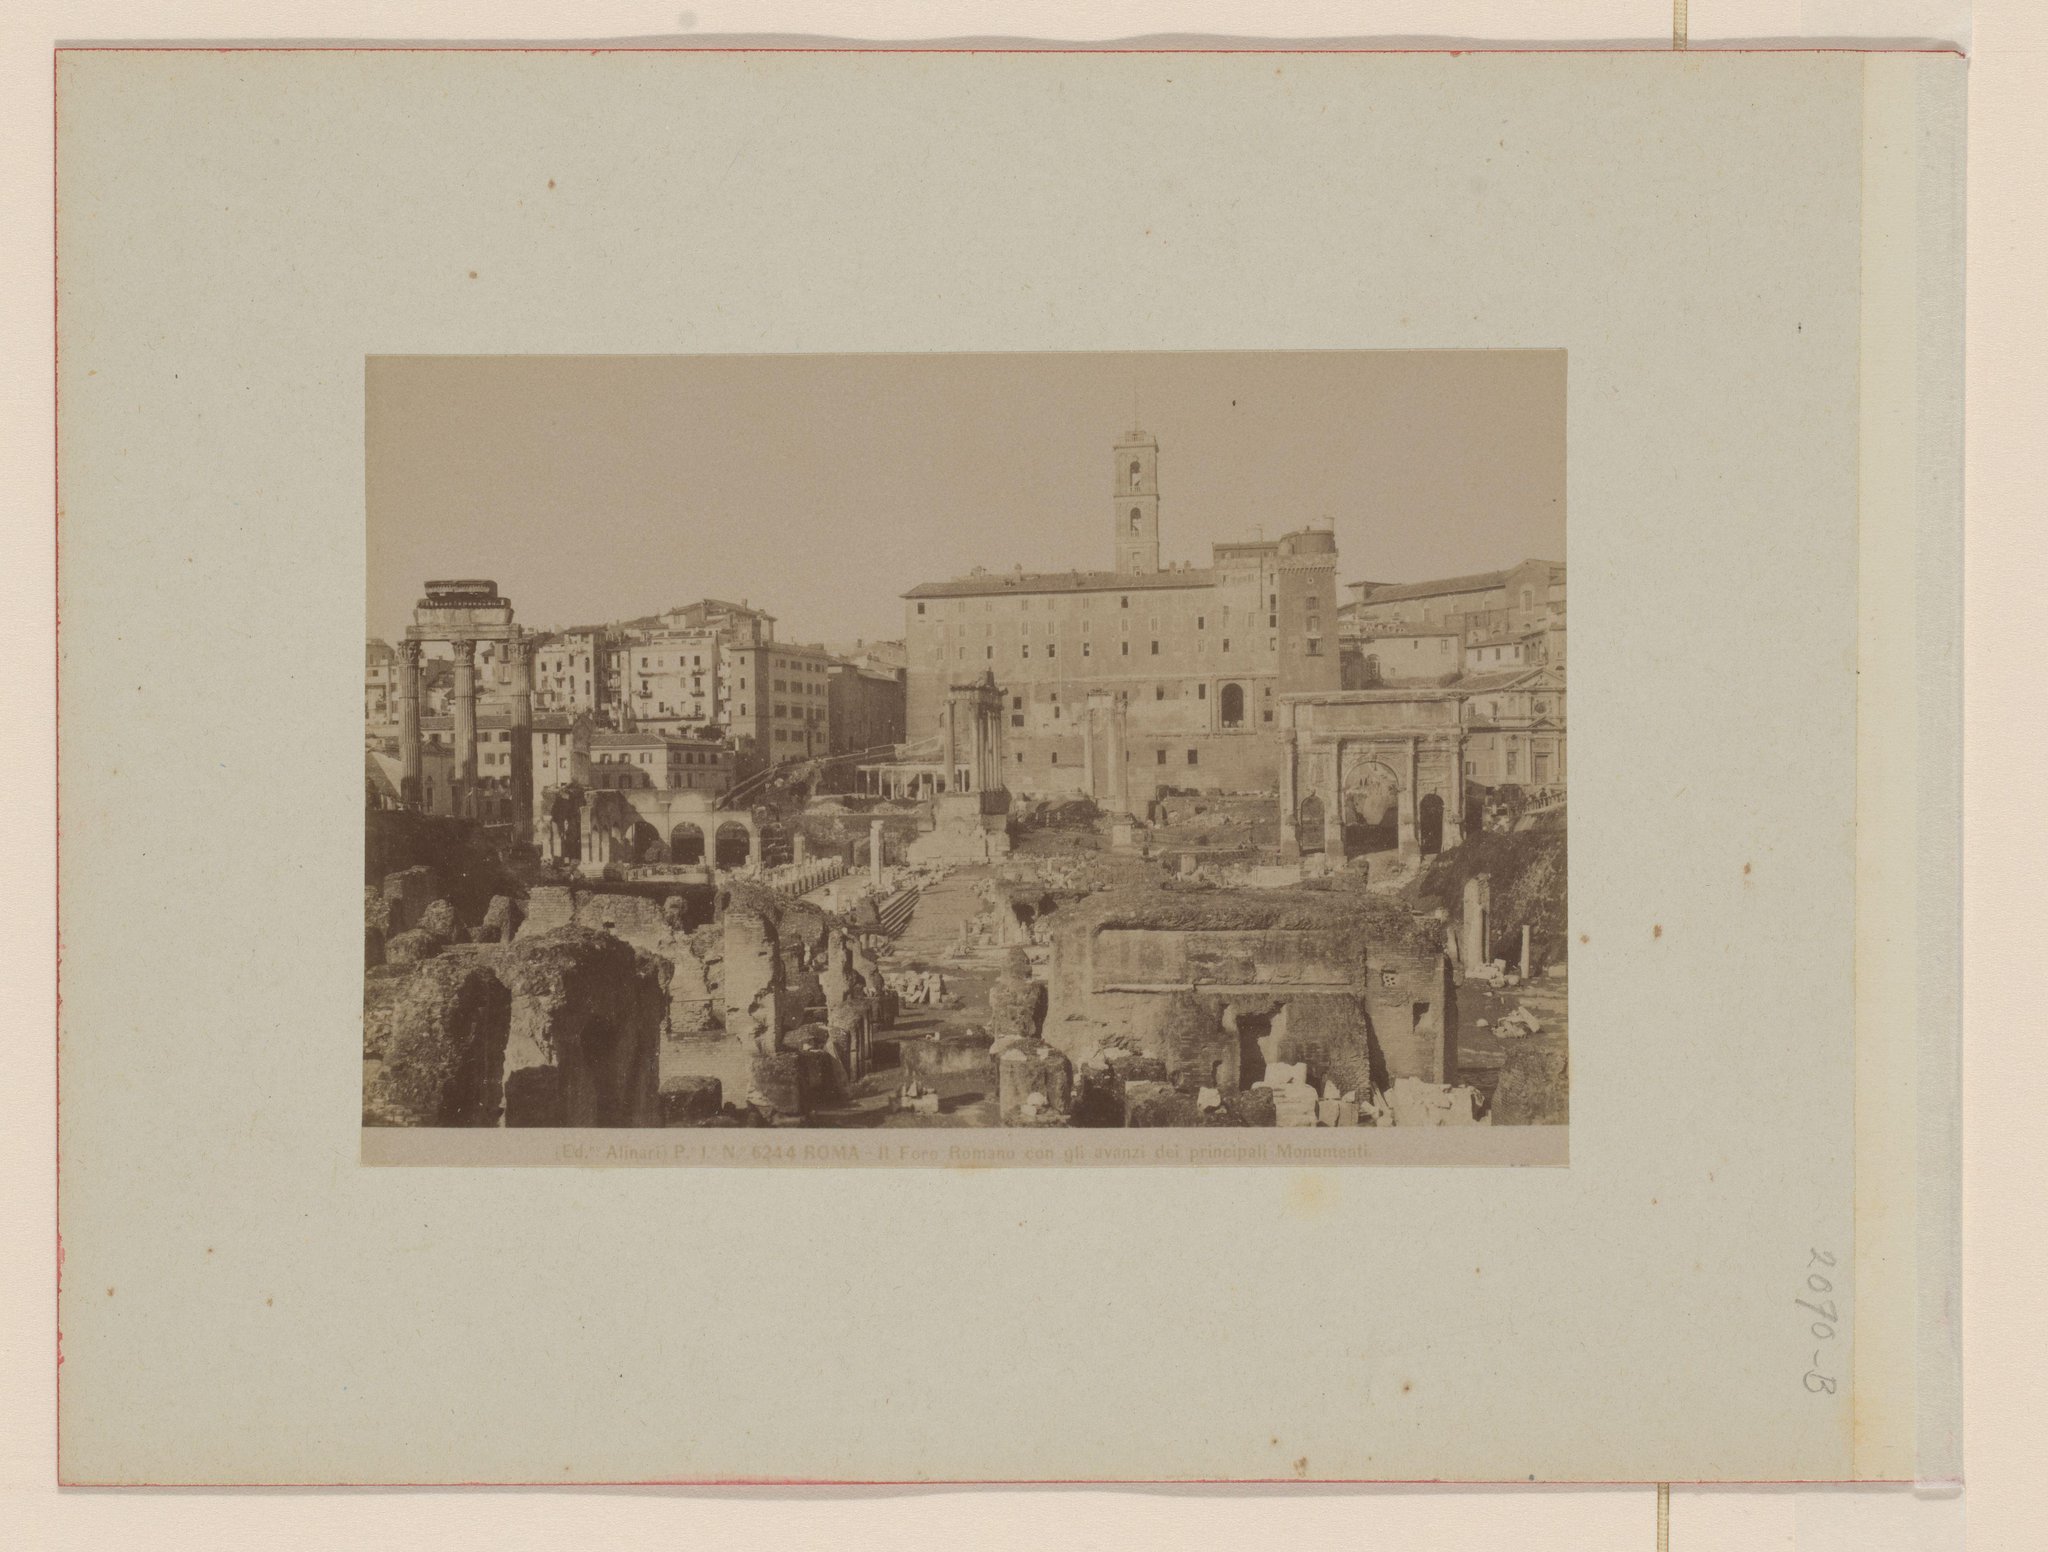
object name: photograph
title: Il Foro Romano con gli avanzi dei principali Monumenti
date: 1857-1900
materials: cardboard, paper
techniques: albumen print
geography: rome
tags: landscape with ruins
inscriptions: number: ‘Pe.Ia.No. 6244’